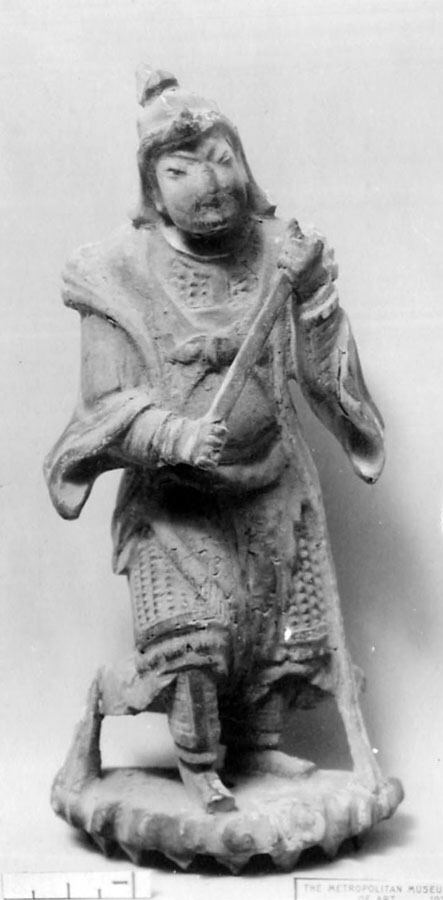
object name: statuette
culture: chinese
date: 1701-1800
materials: wood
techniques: painting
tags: men